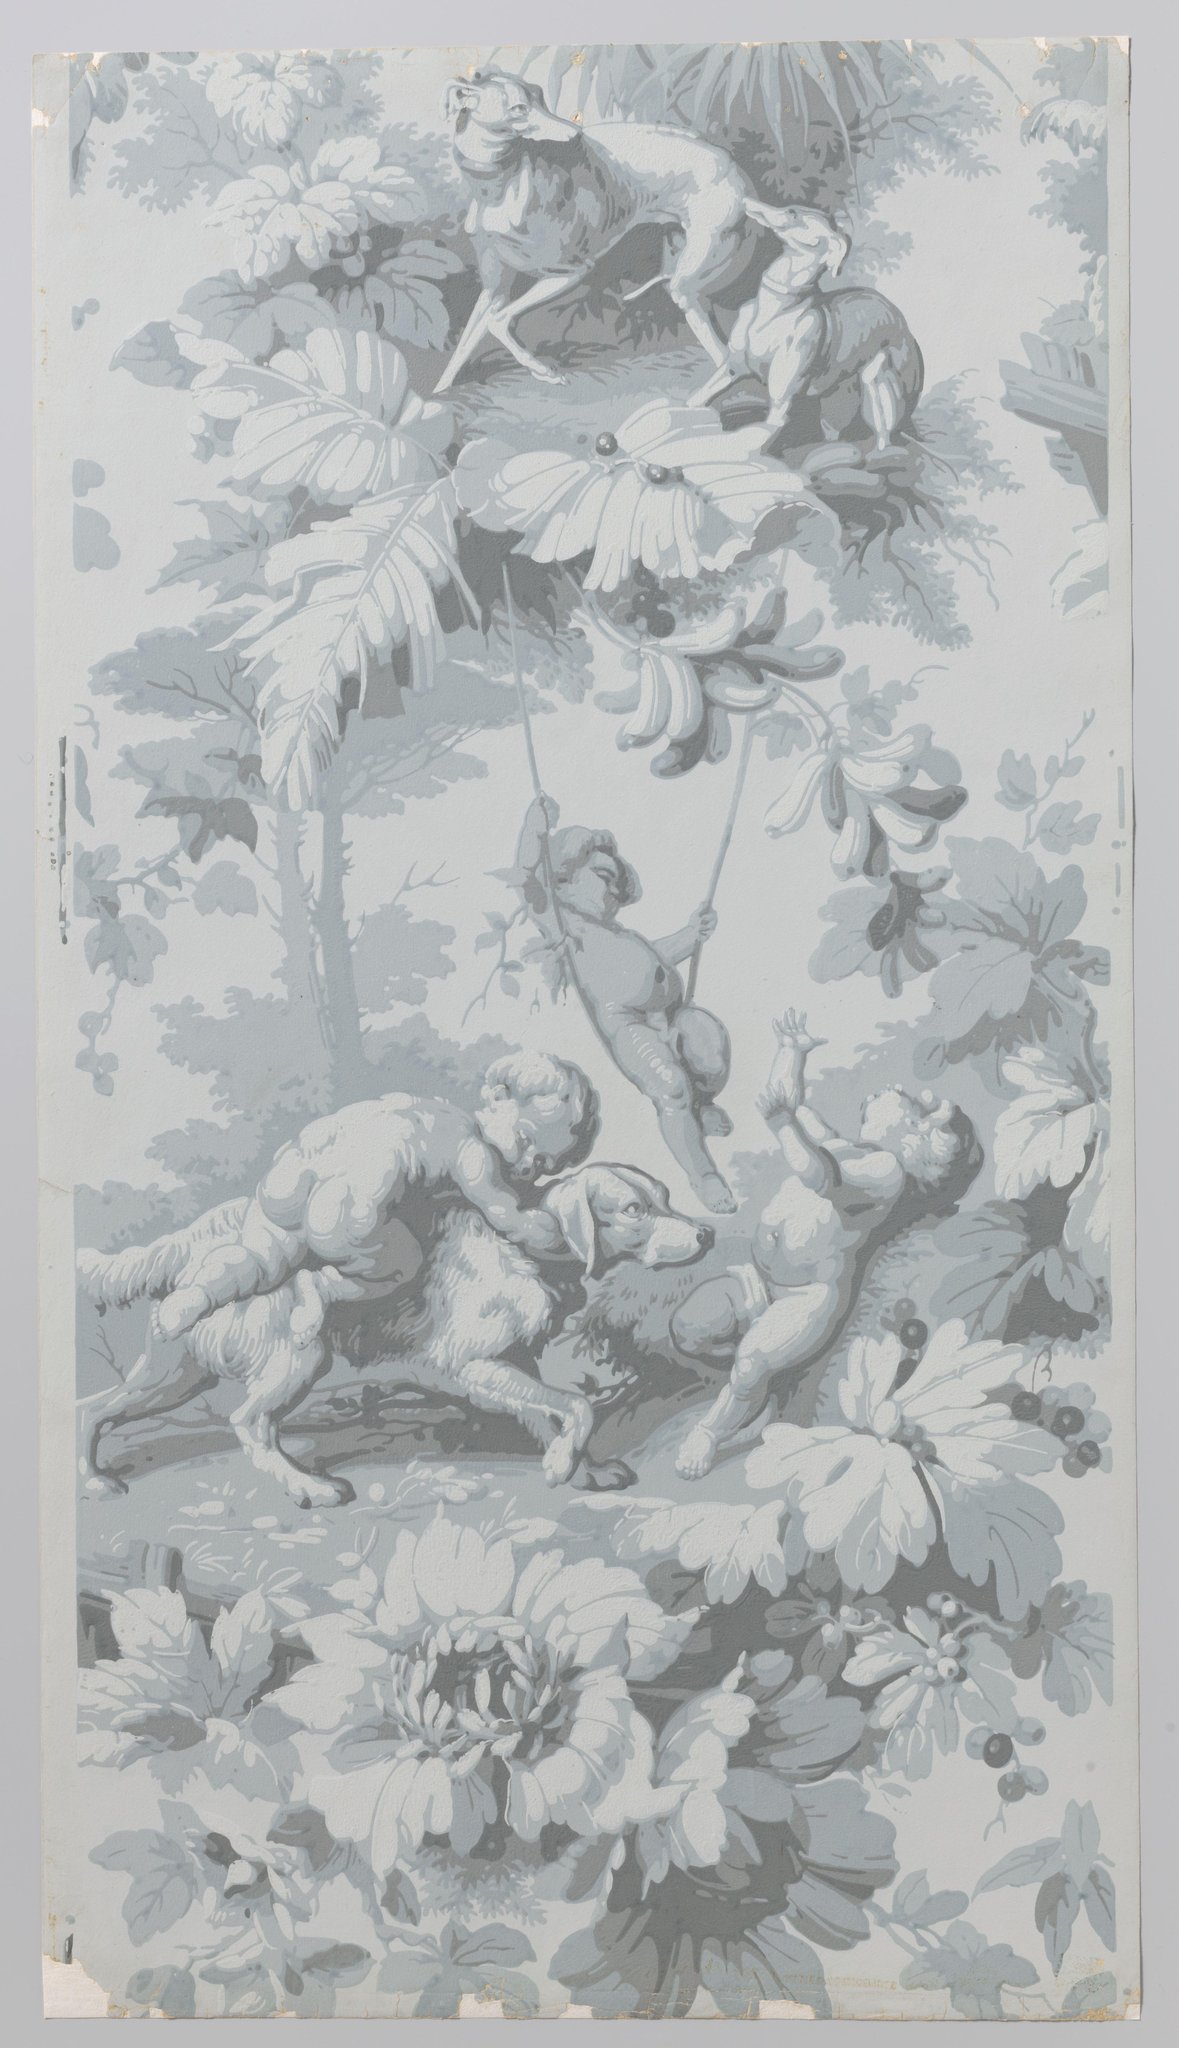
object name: interieuronderdeel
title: Papierbehangsel met decor van spelende kinderen en honden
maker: benedetto pastorini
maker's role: draughtsman, print maker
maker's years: 1746-1803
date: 1855-1906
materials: paper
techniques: printing block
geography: paris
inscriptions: inscription: ‘2594/10196’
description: Papierbehangsel met decor in blokdruk op gesatineerde grond van spelende kinderen en honden, bladeren en bloemen in vijf tinten grijs op een écru fond. Doorlopend patroon. Aan de achterzijde met potlood het dubbelnummer 2594/10196.